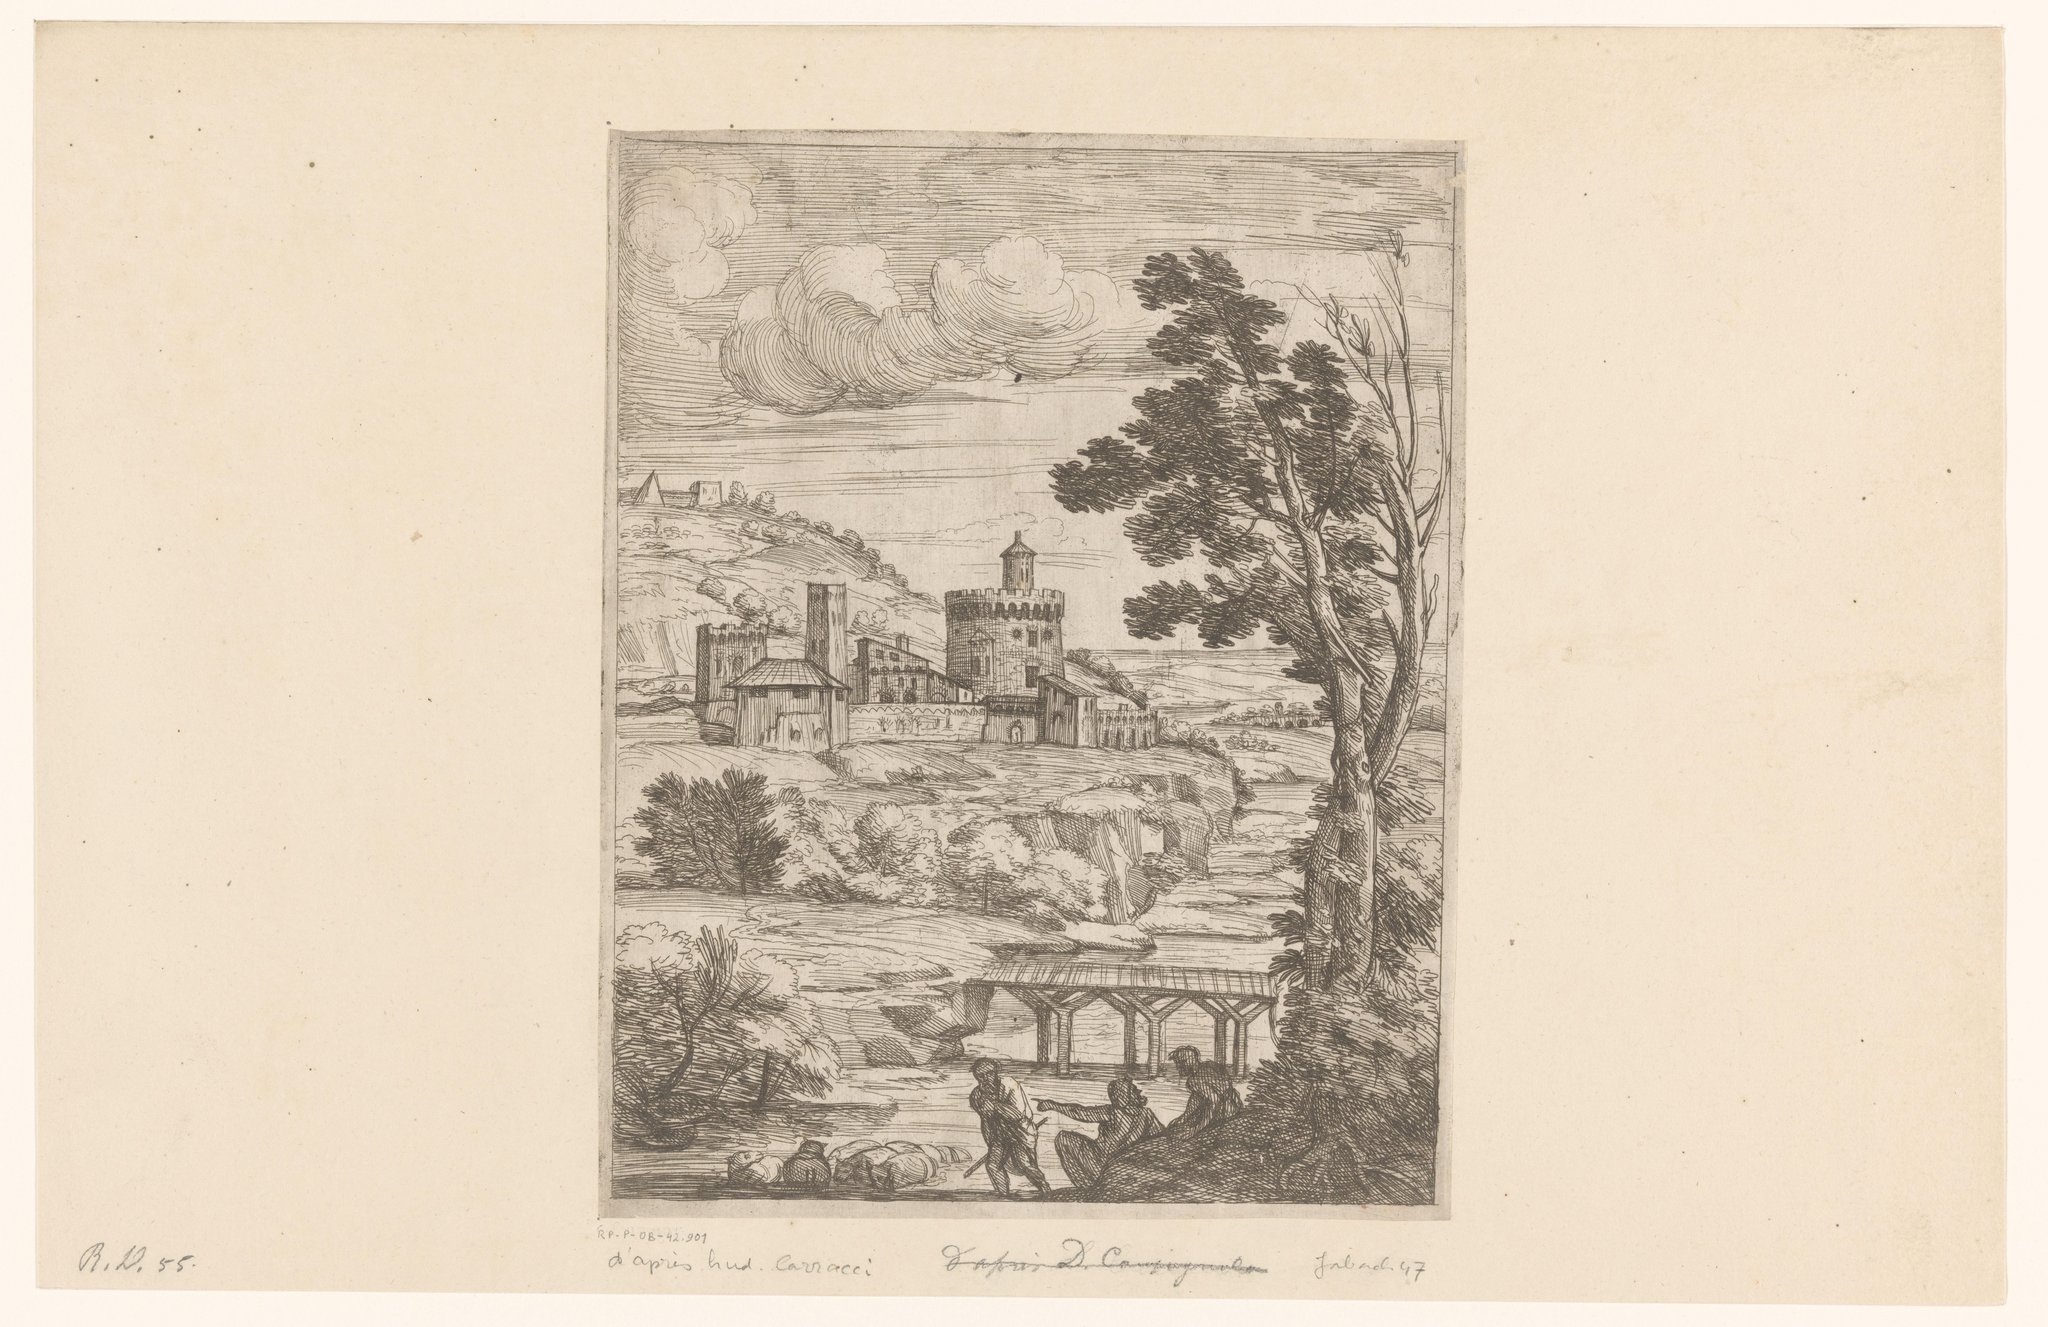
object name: print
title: Rivierlandschap met kasteel en herders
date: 1659-1695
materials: paper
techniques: drypoint, etching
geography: france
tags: fortress, river, herding, herdsman, herdswoman, shepherd, shepherdess, cowherd, etc., herd, flock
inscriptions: collector's mark: Lugt 240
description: Prenten naar tekeningen uit het kabinet Jabach